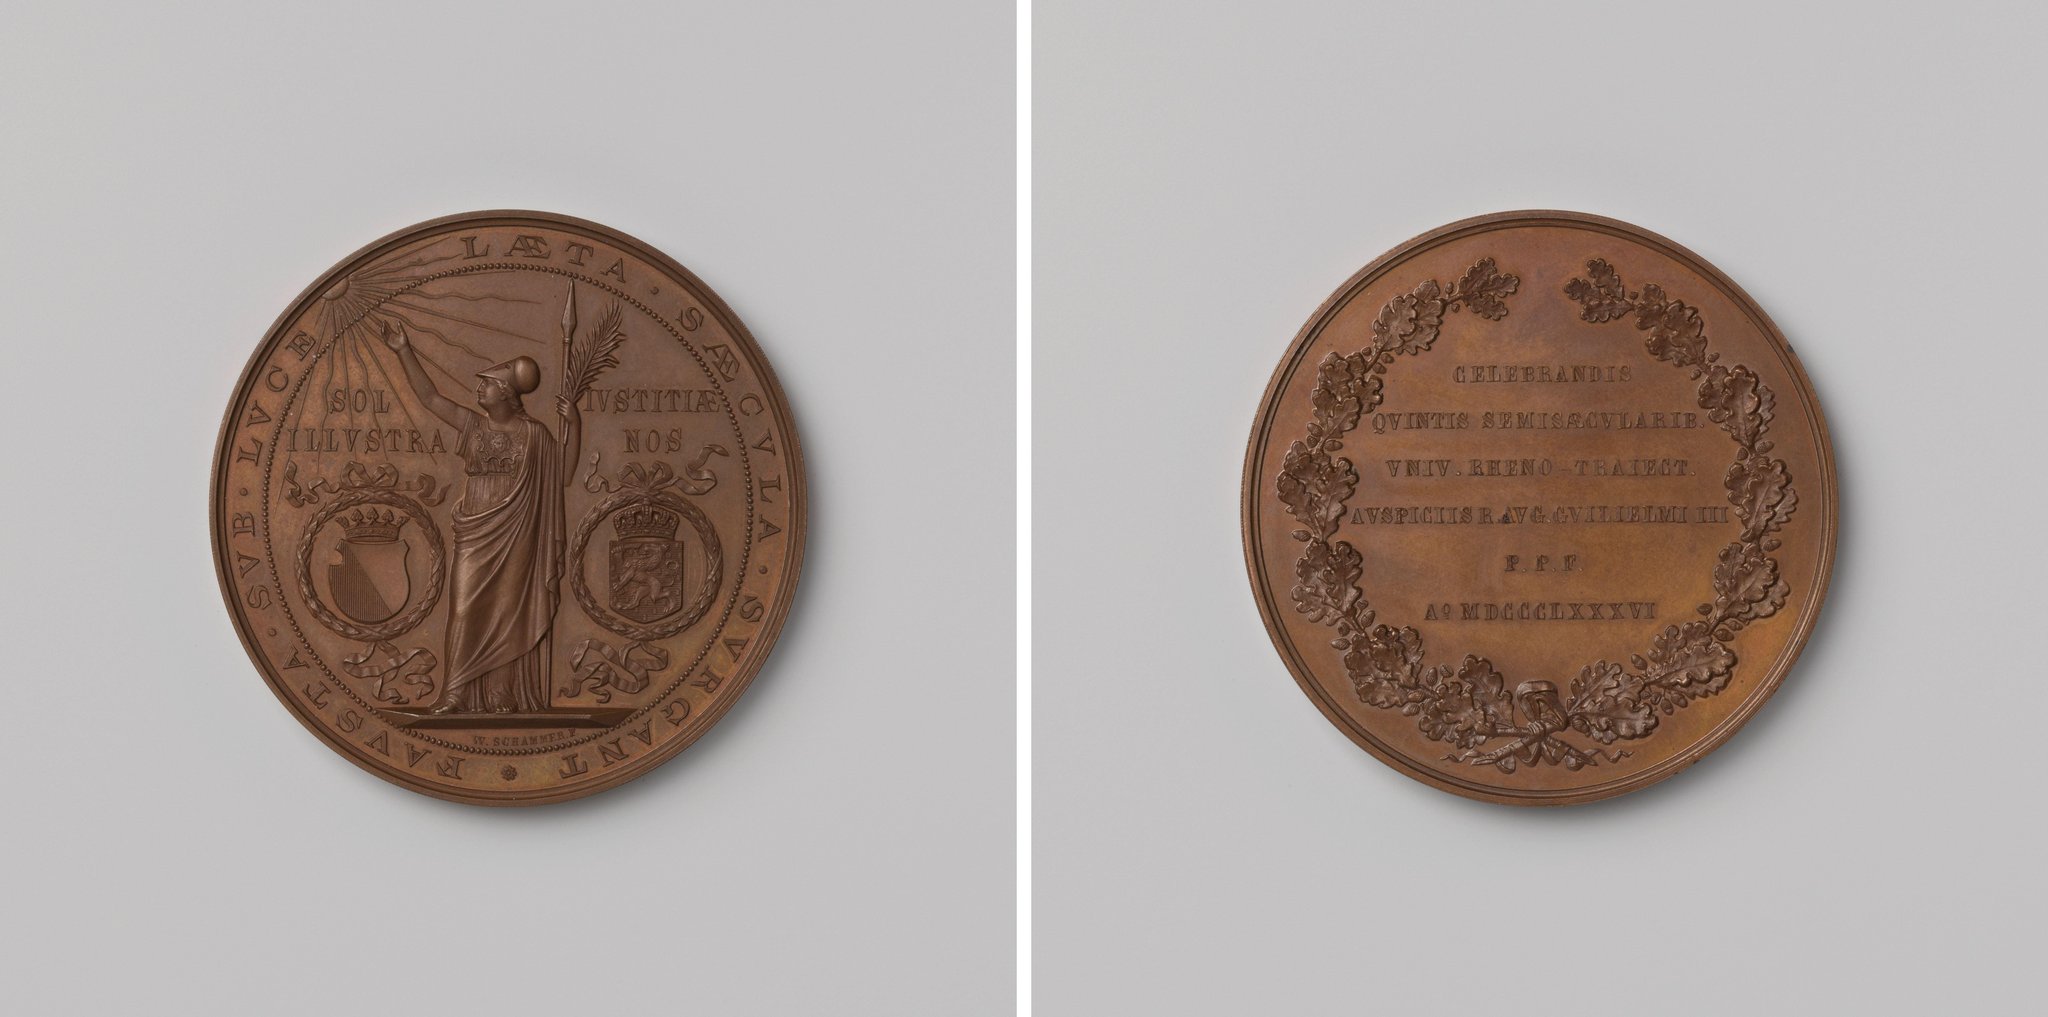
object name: history medal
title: Tweehonderdenvijftigjarig bestaan van de universiteit van Utrecht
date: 1886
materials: bronze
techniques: striking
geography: utrecht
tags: brussels, willem iii (koning der nederlanden), utrecht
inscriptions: circumscription: ‘L ÆTA . SÆCVLA . SVRGANT . FAVSTA . SVB . LVCE.’, inscription: ‘CELEBRANDIS QVINTIS SEMISÆ CVLARIB . VNIV . RHENO - TRAIECT . AVSPICIIS R. AVG . GVILIELMI III P.P.F. Ao MDCCCLXXXVI’, signature: ‘W. SCHAMMER . F.’, inscription: ‘SOL IVSTITIÆ ILLVSTRA NOS’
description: Bronzen penning. Voorzijde: staande tussen twee gekroonde wapenschilden, elk binnen lauwerkrans onder opschrift heft gehelmde Minerva met speer en palmtak in linkerhand, haar rechterhand op naar stralende zon binnen omschrift. Keerzijde: opschrift binnen eikekrans.